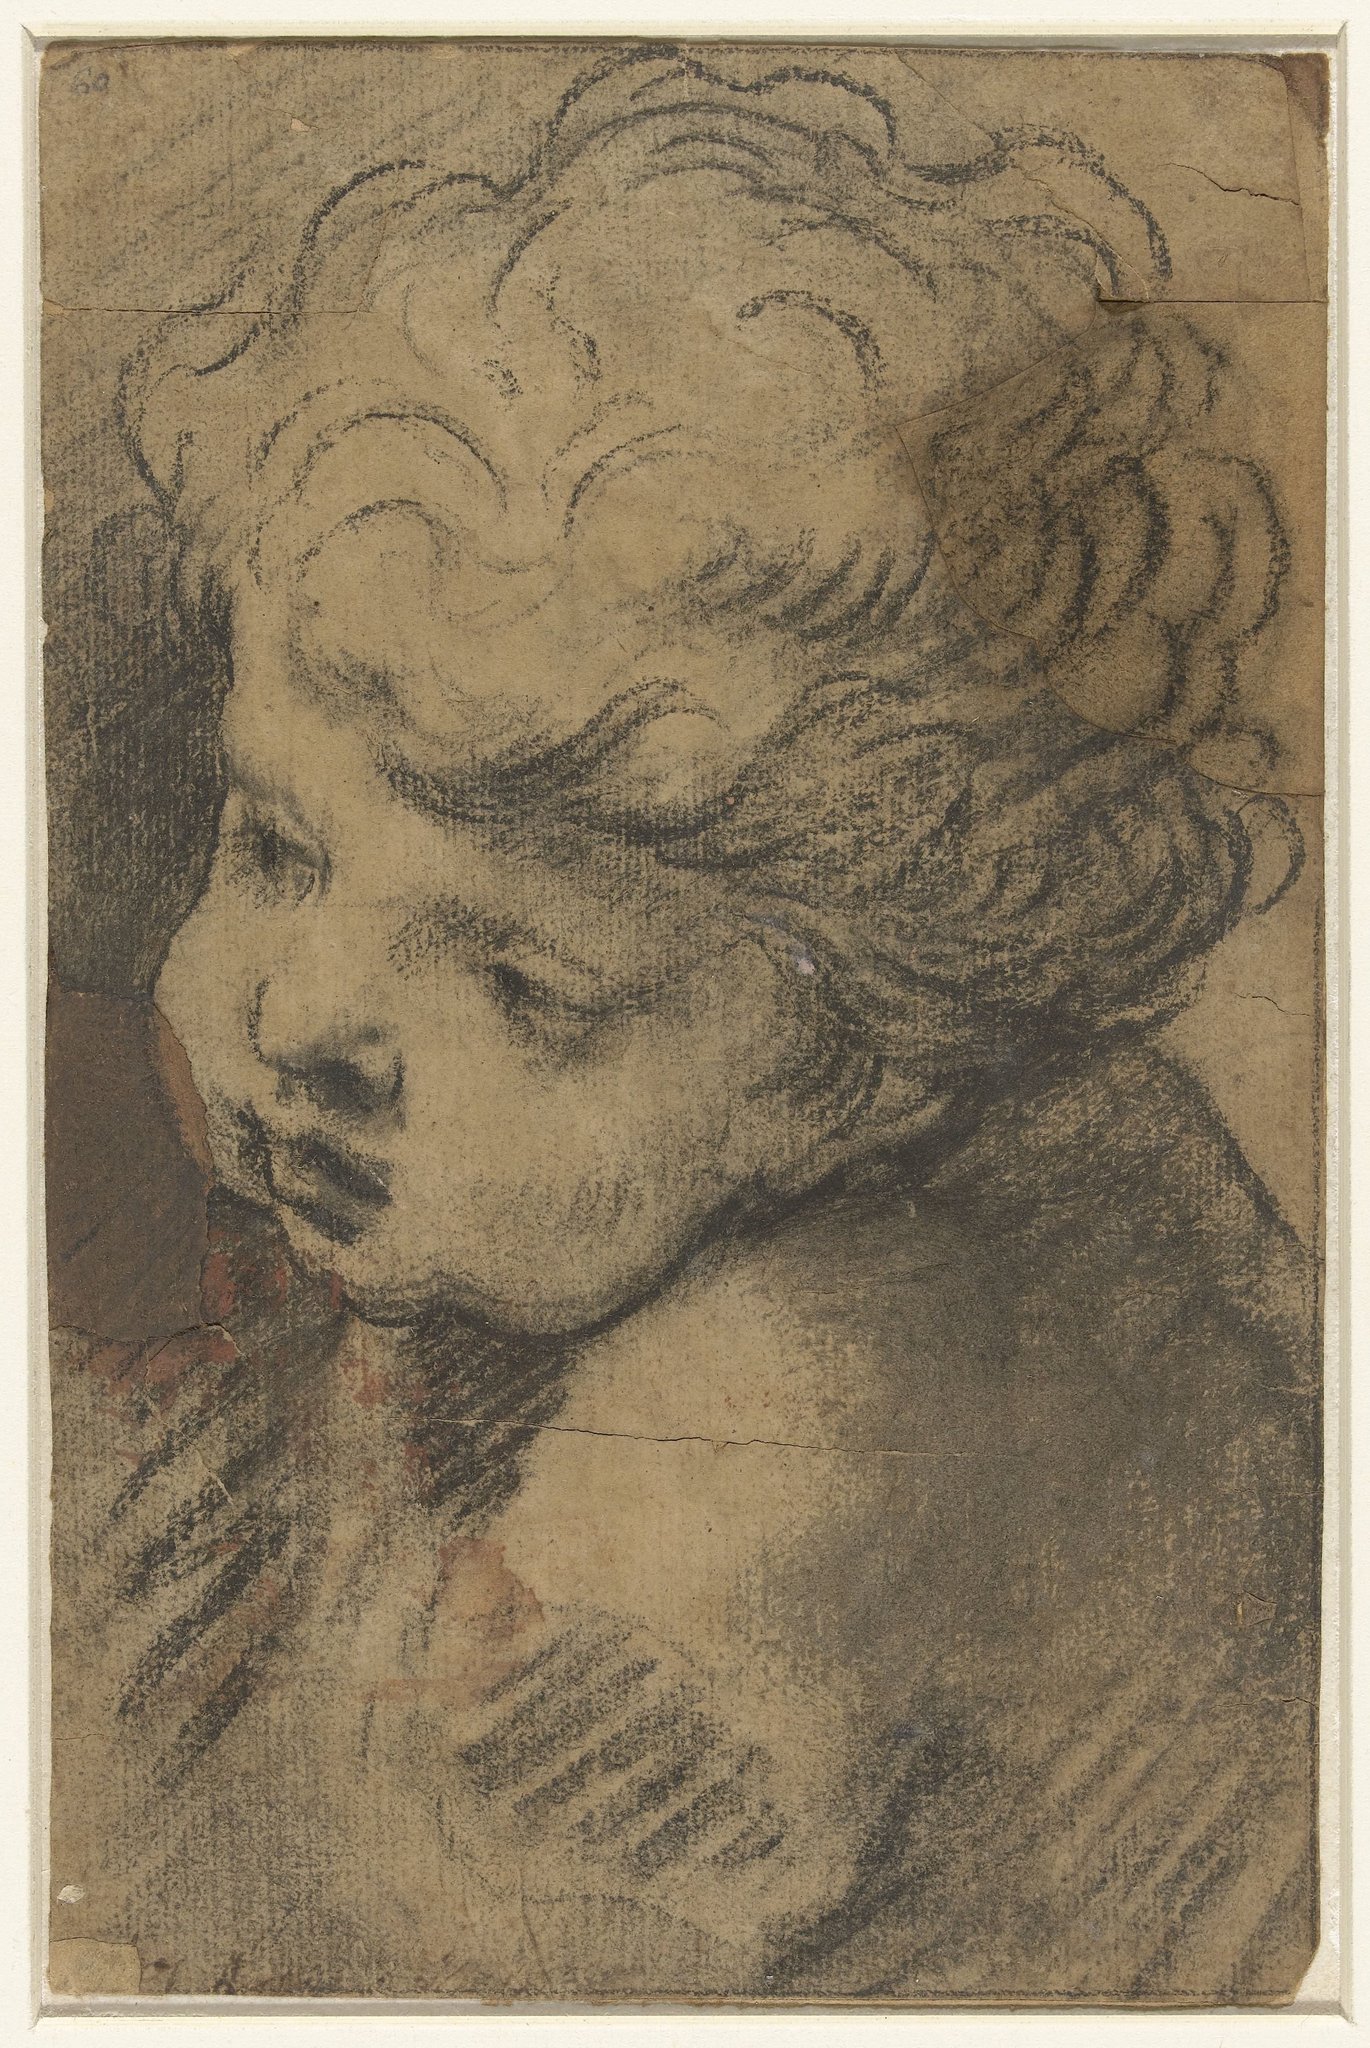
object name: drawing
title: Hoofd van een putto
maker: giacomo cavedone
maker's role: draughtsman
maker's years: 1577-1660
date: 1587-1660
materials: chalk, paper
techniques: brush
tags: child, cupids: 'amores', 'amoretti', 'putti'